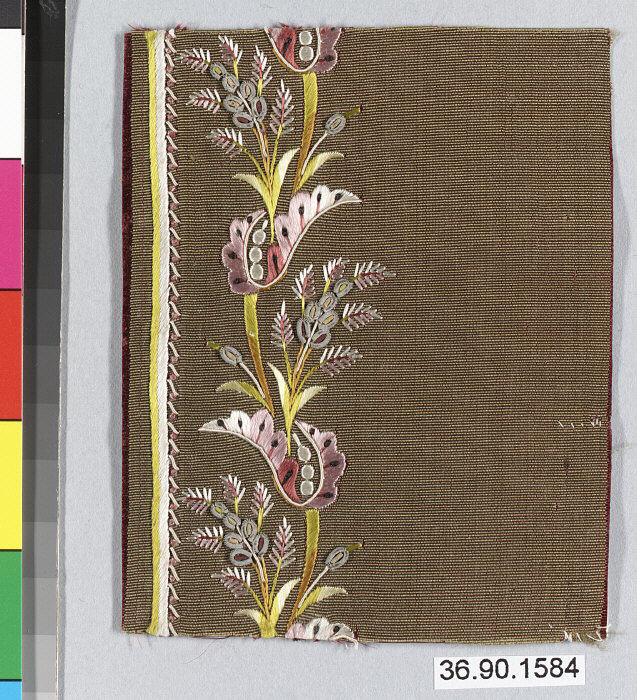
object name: sample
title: Embroidery sample for a man’s suit or waistcoat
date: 1785-1815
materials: metal thread, silk